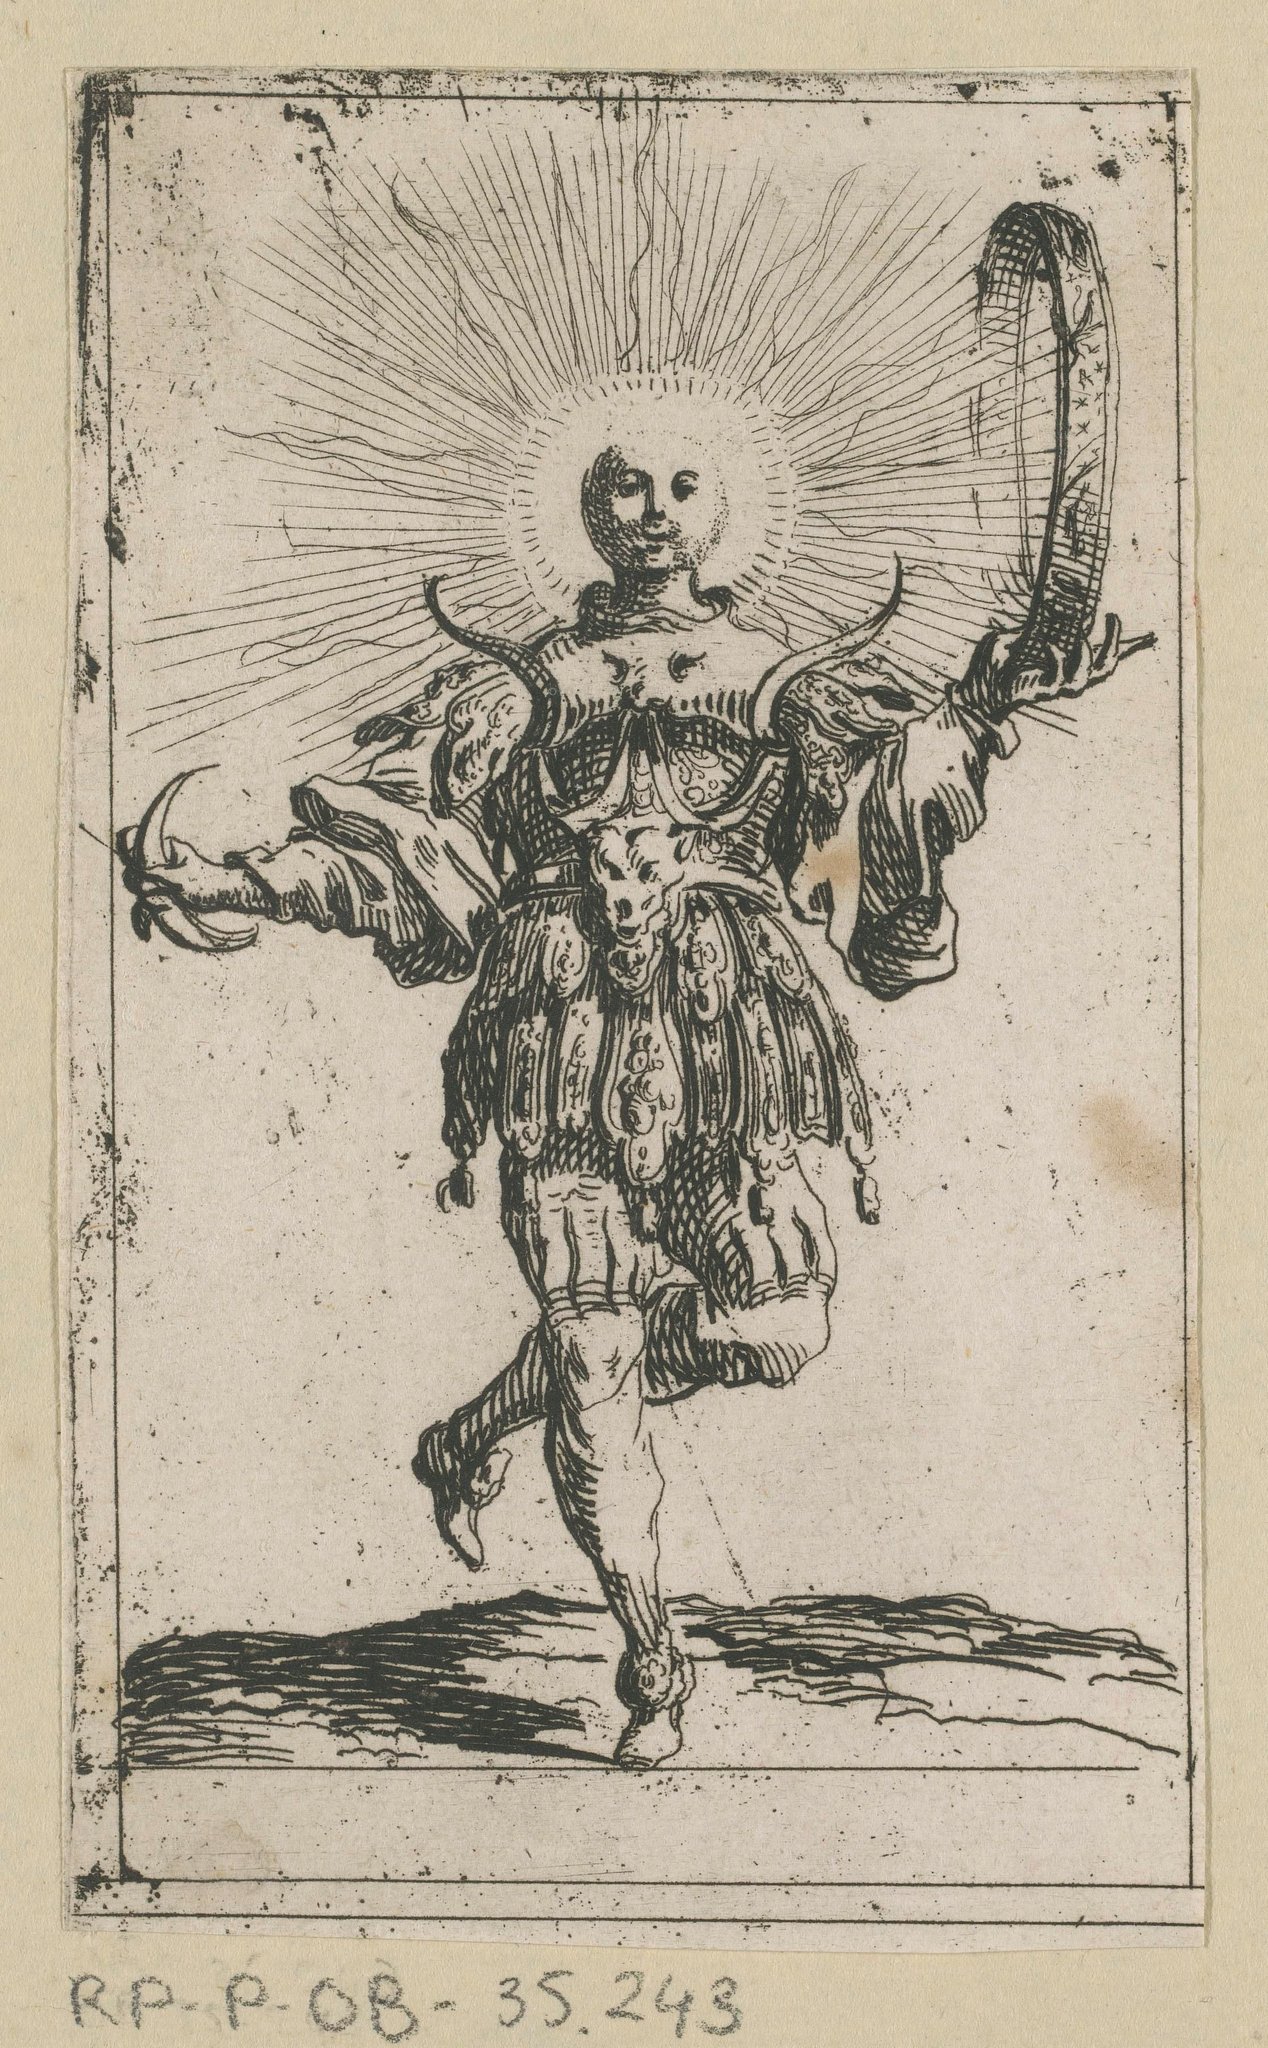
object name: ornament print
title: Juni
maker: denis boutemie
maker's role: print maker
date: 1633-1643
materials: paper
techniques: etching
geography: paris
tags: june; 'giugno' (ripa)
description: Personificatie van de maand juni. Een grotesk figuur met een stralenkrans rondom haar hoofd. De figuur danst en houdt een halve maan en een trommel met hiërogliefen in haar handen.